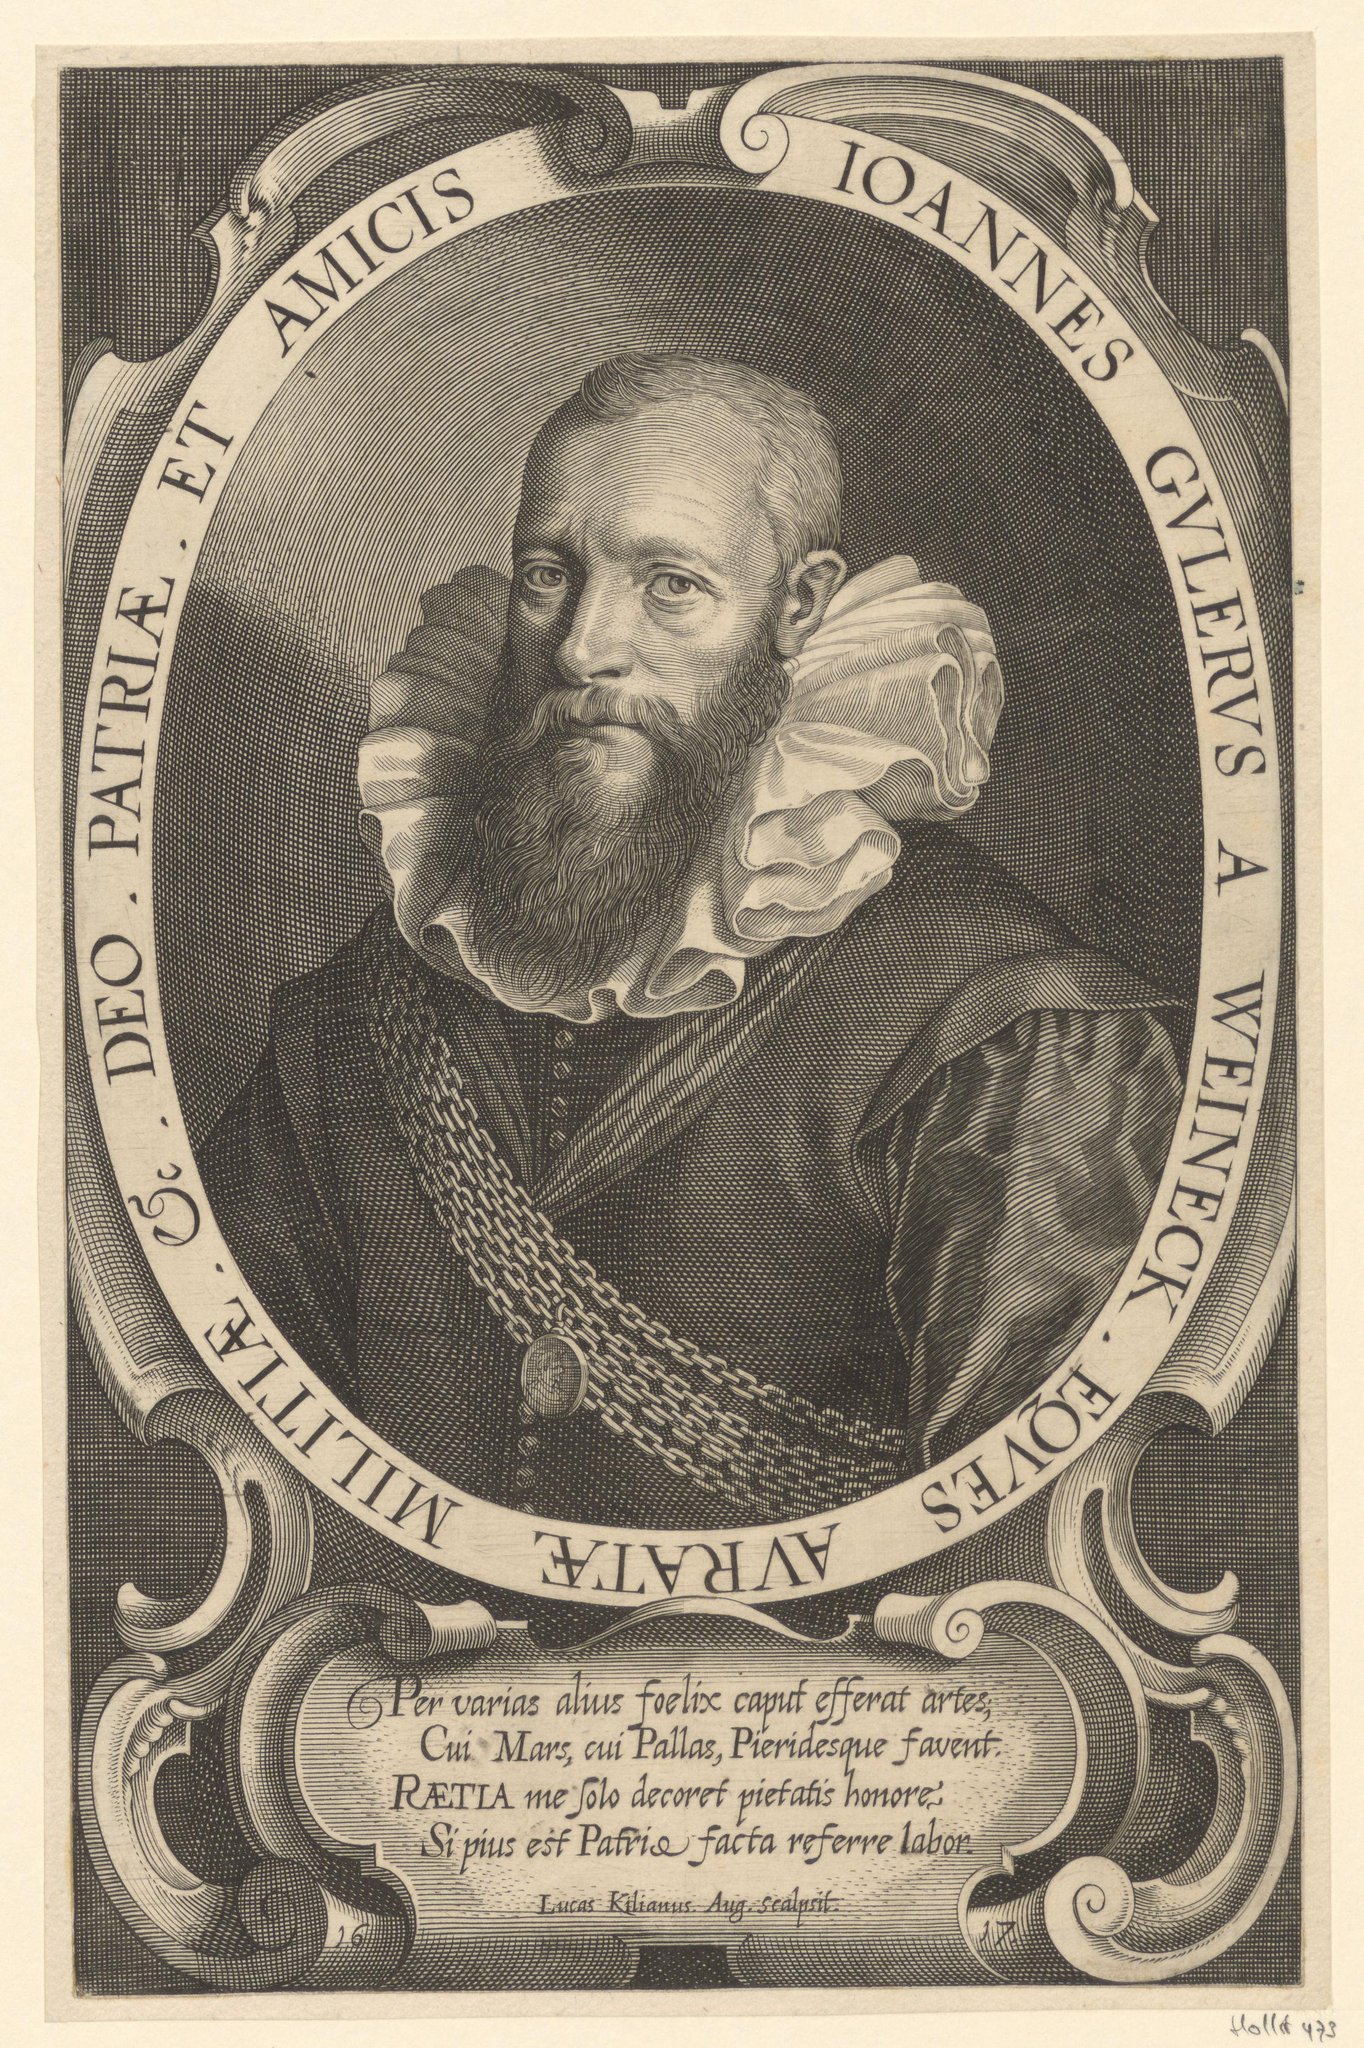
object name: print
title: Portret van Johannes Guler von Wyneck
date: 1617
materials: paper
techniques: engraving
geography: augsburg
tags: switzerland, historical persons, officer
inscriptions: collector's mark: Lugt 2228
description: Tekst in het Latijn in de omlijsting en in de cartouche.